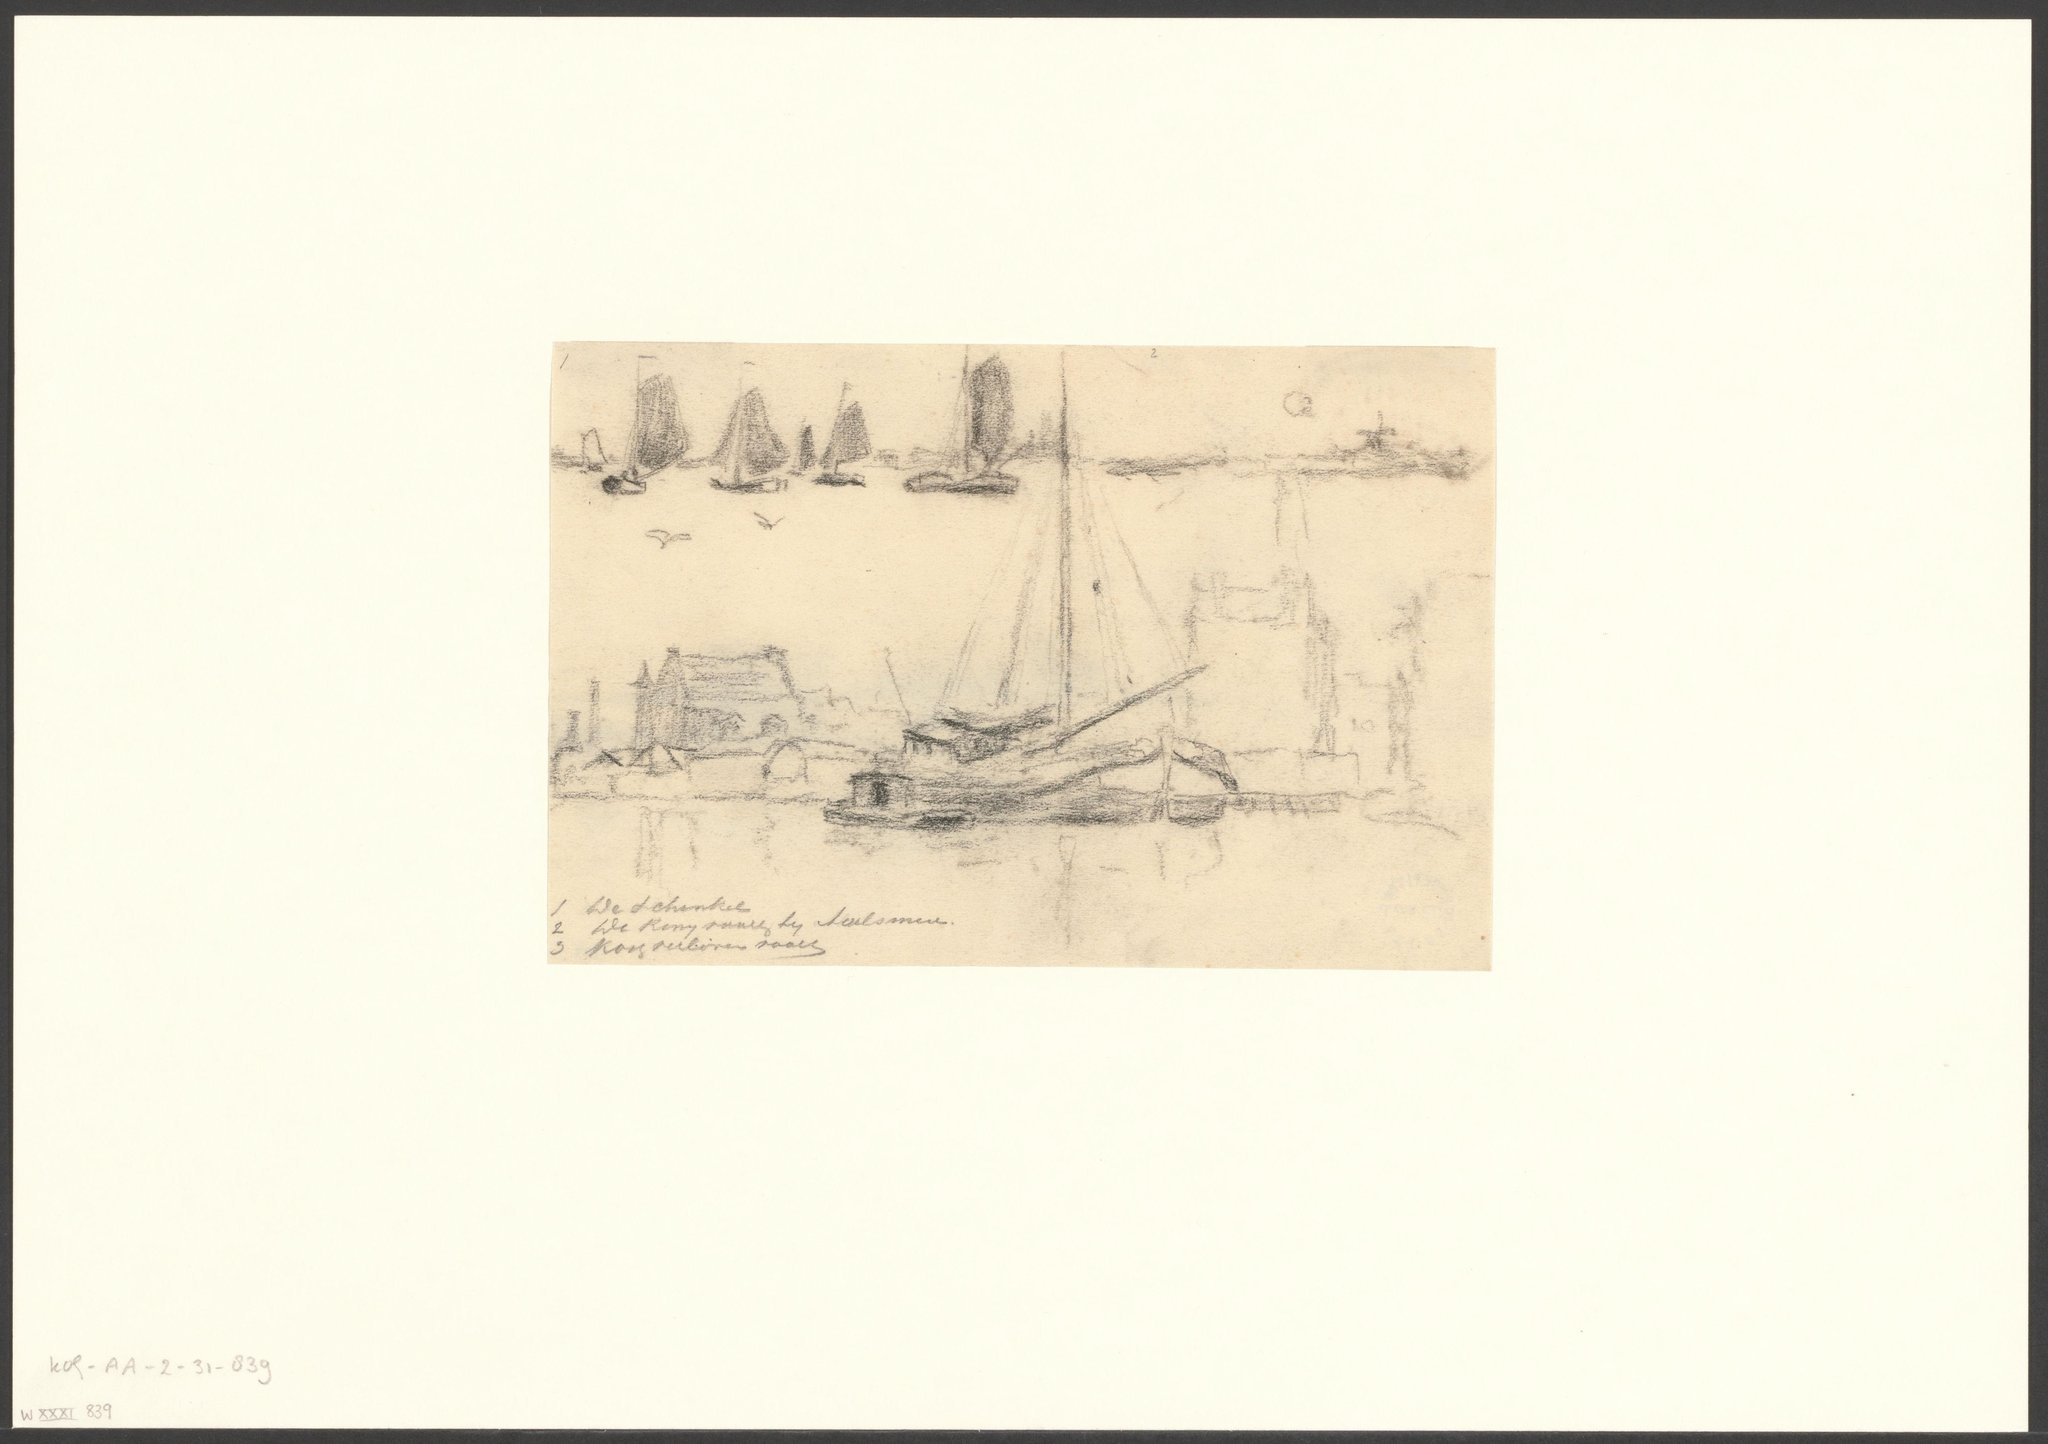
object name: drawing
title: Gezicht op enkele zeilboten op de Schinkel, de Ringvaart en de Kostverlorenvaart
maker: Anonymous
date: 1850-1950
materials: chalk, paper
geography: amsterdam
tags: sailing-ship, sailing-boat, city-view in general; 'veduta', river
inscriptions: inscription: ‘1 De Schinkel / 2 de Ringvaart bij Aalsmeer / 3 Kostverlorenvaart’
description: Tekening binnen de Atlas Van Eck ingedeeld op wijknummer 31.